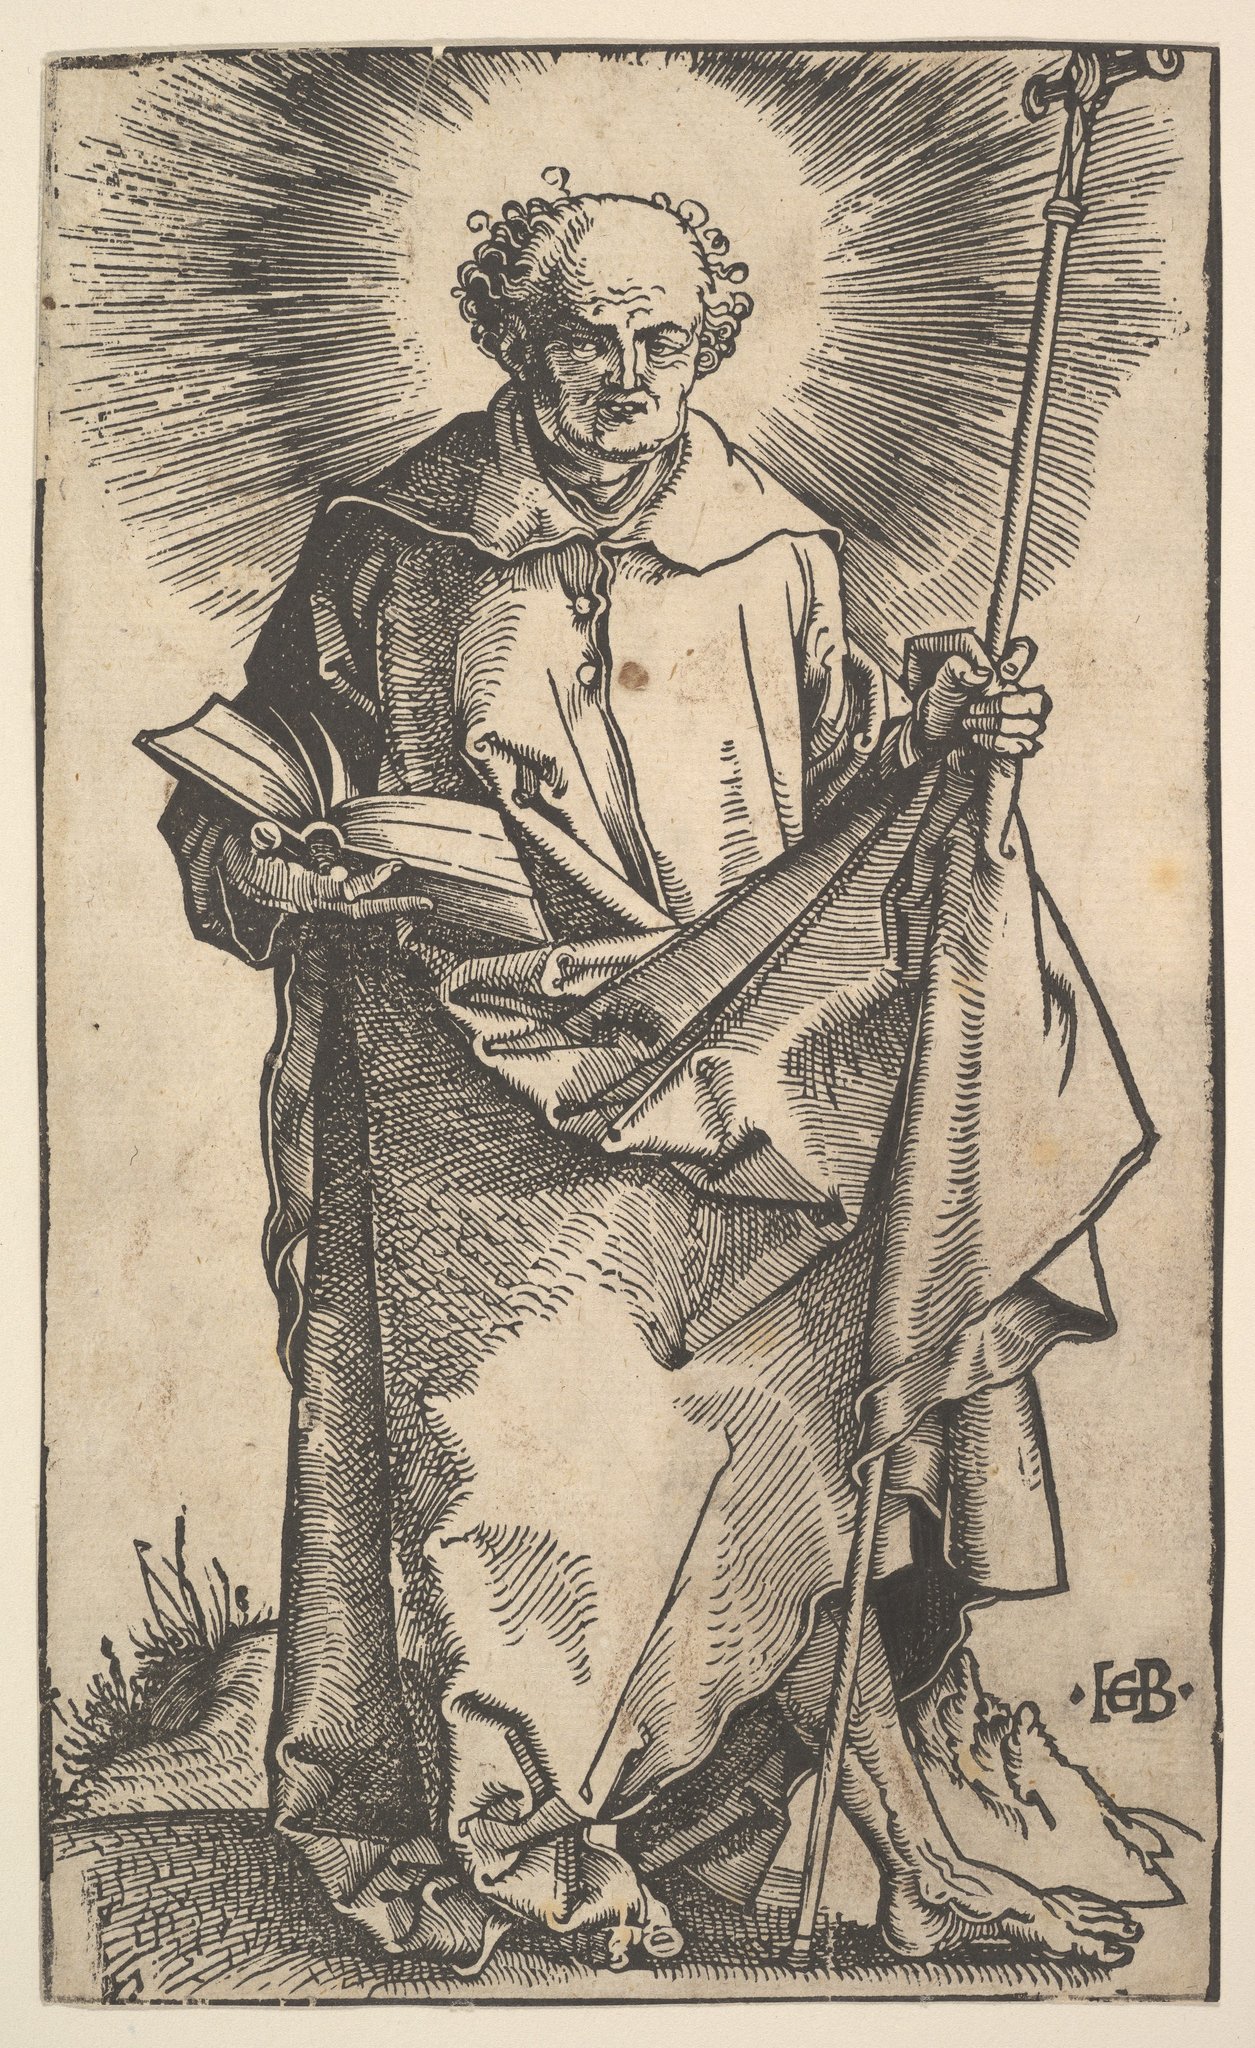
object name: print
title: St. Philip, from "Christ and the Apostles"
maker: hans baldung (called hans baldung grien)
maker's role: artist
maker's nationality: german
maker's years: 1484-1545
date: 1519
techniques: woodcut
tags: men,saints